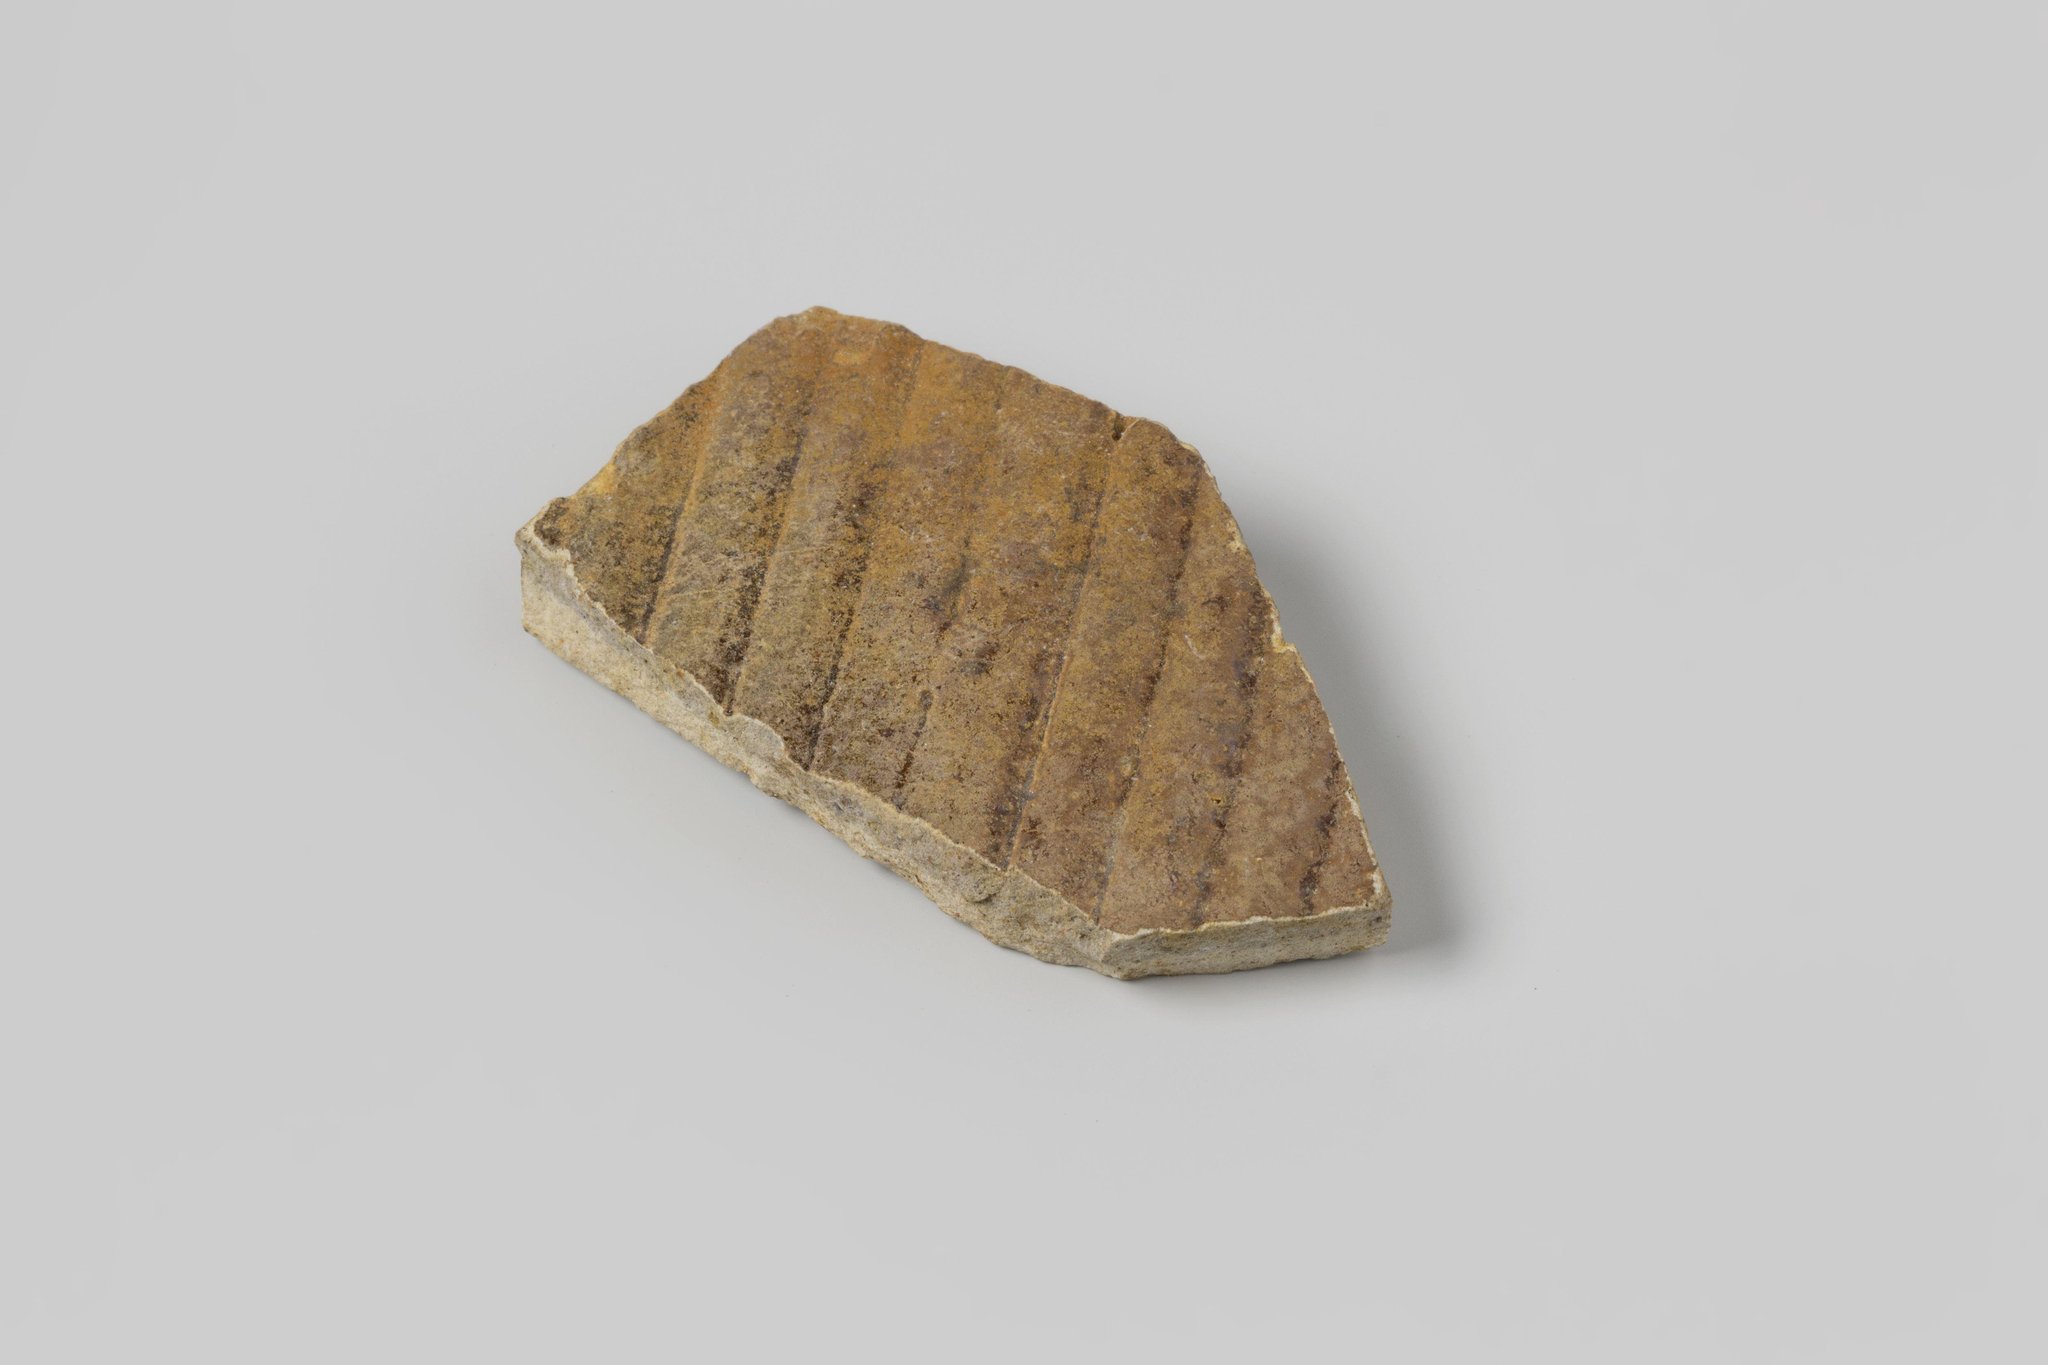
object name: sherd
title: Scherf van een voorraadpot uit het wrak van de Oost-Indiëvaarder Hollandia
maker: Anonymous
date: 1700-1743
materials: stoneware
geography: cologne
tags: verenigde oostindische compagnie, hollandia (schip), annet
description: Stoneware, Rhenish, Langerwehe-ware, storage-jar; fragm of body, sim. NG 1980-27H409.